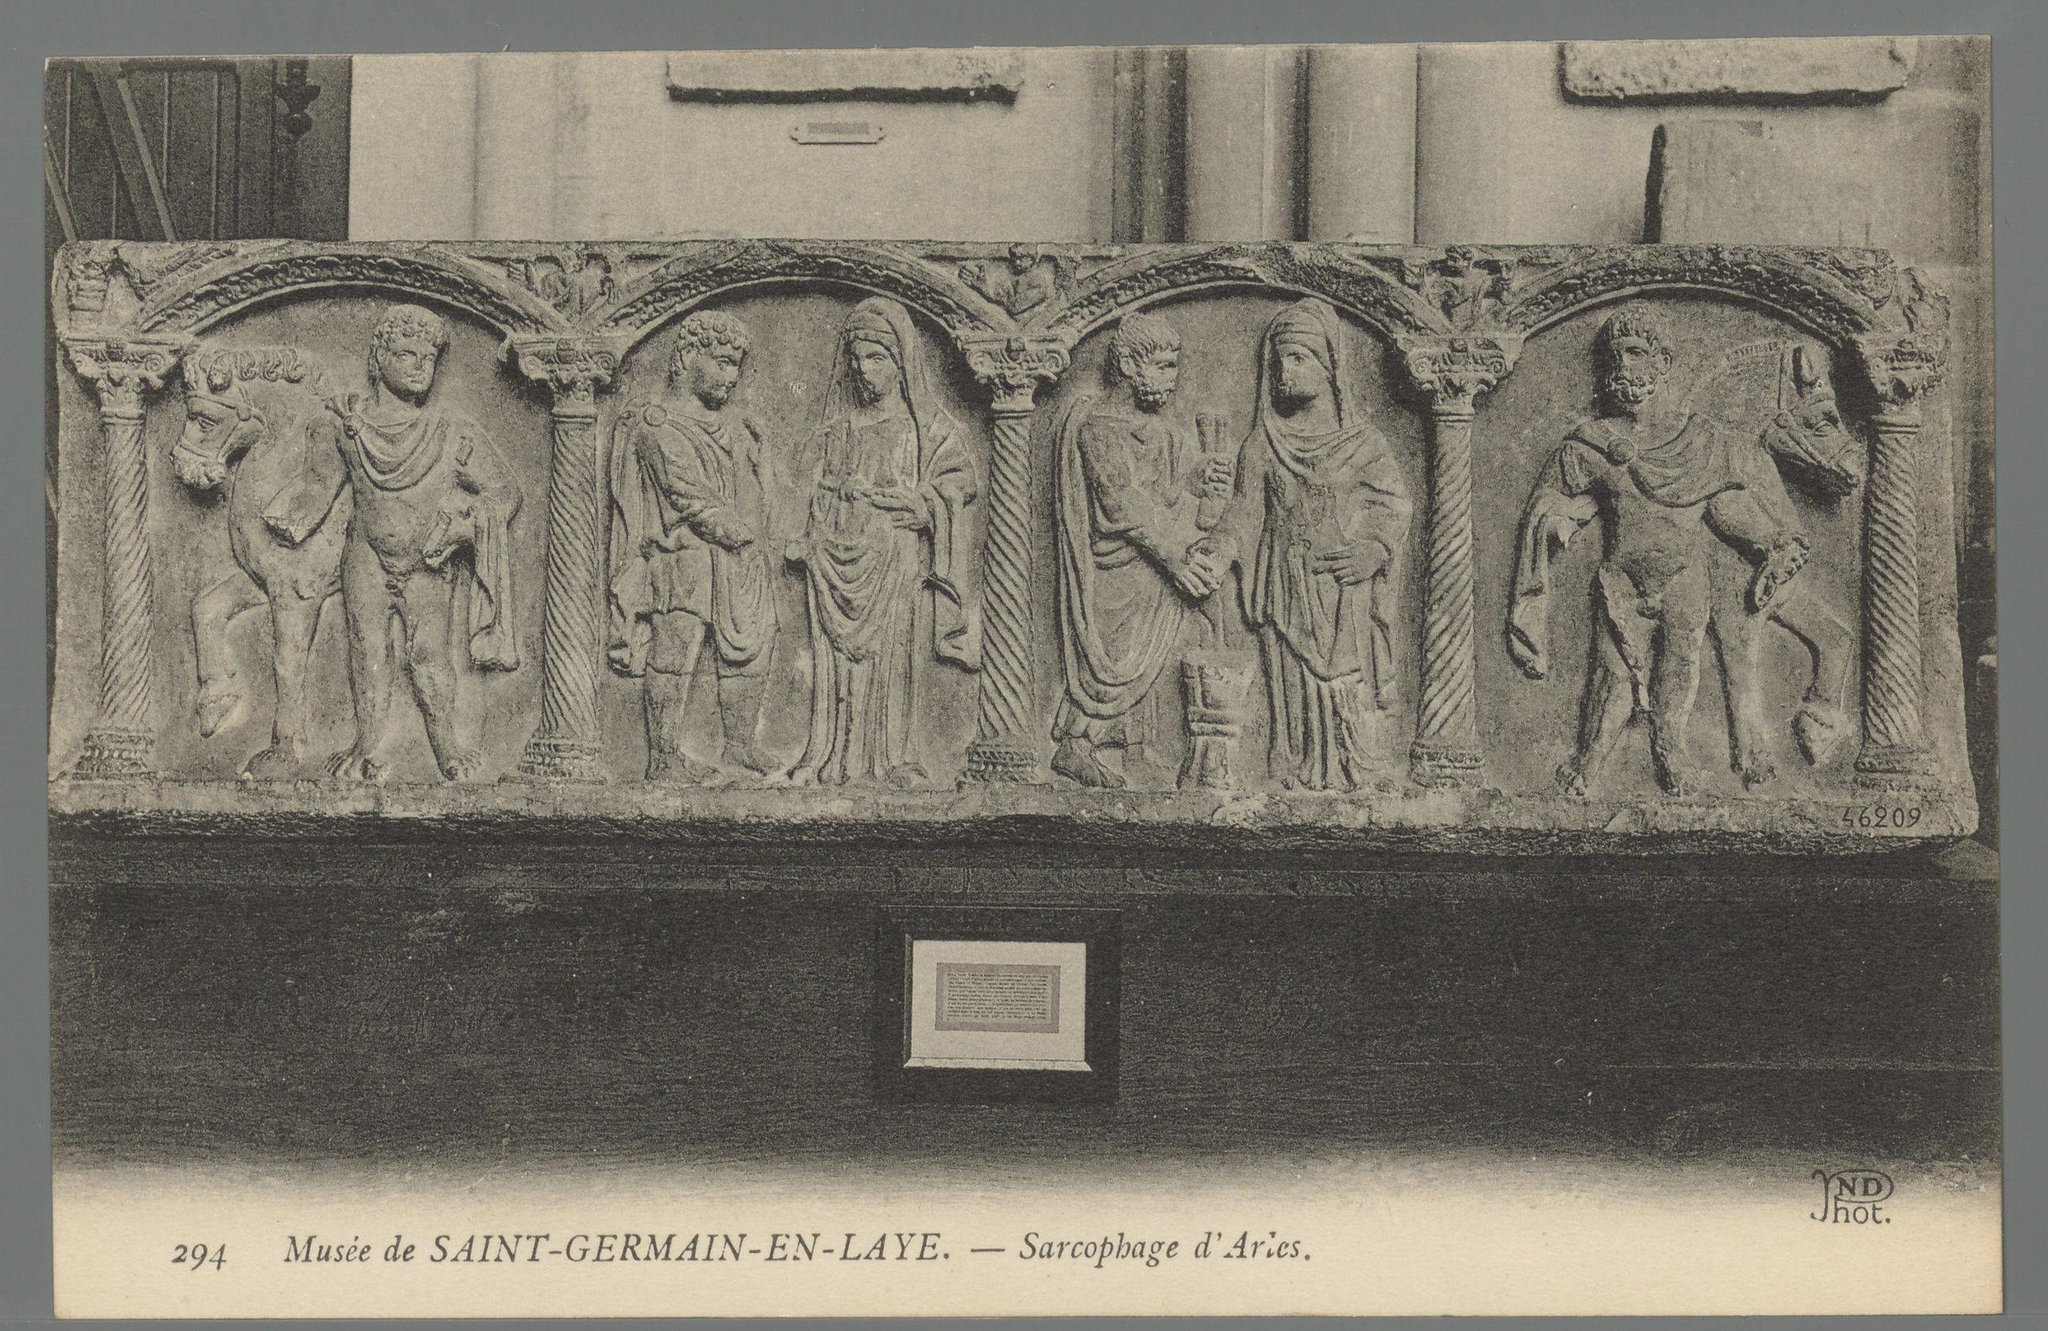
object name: photomechanical print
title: Sarcophage d'Arles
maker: Anonymous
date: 1903-1918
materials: cardboard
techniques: photograph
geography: saint-germain-en-laye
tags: sarcophagus, permanent exhibition, museum, sculpture